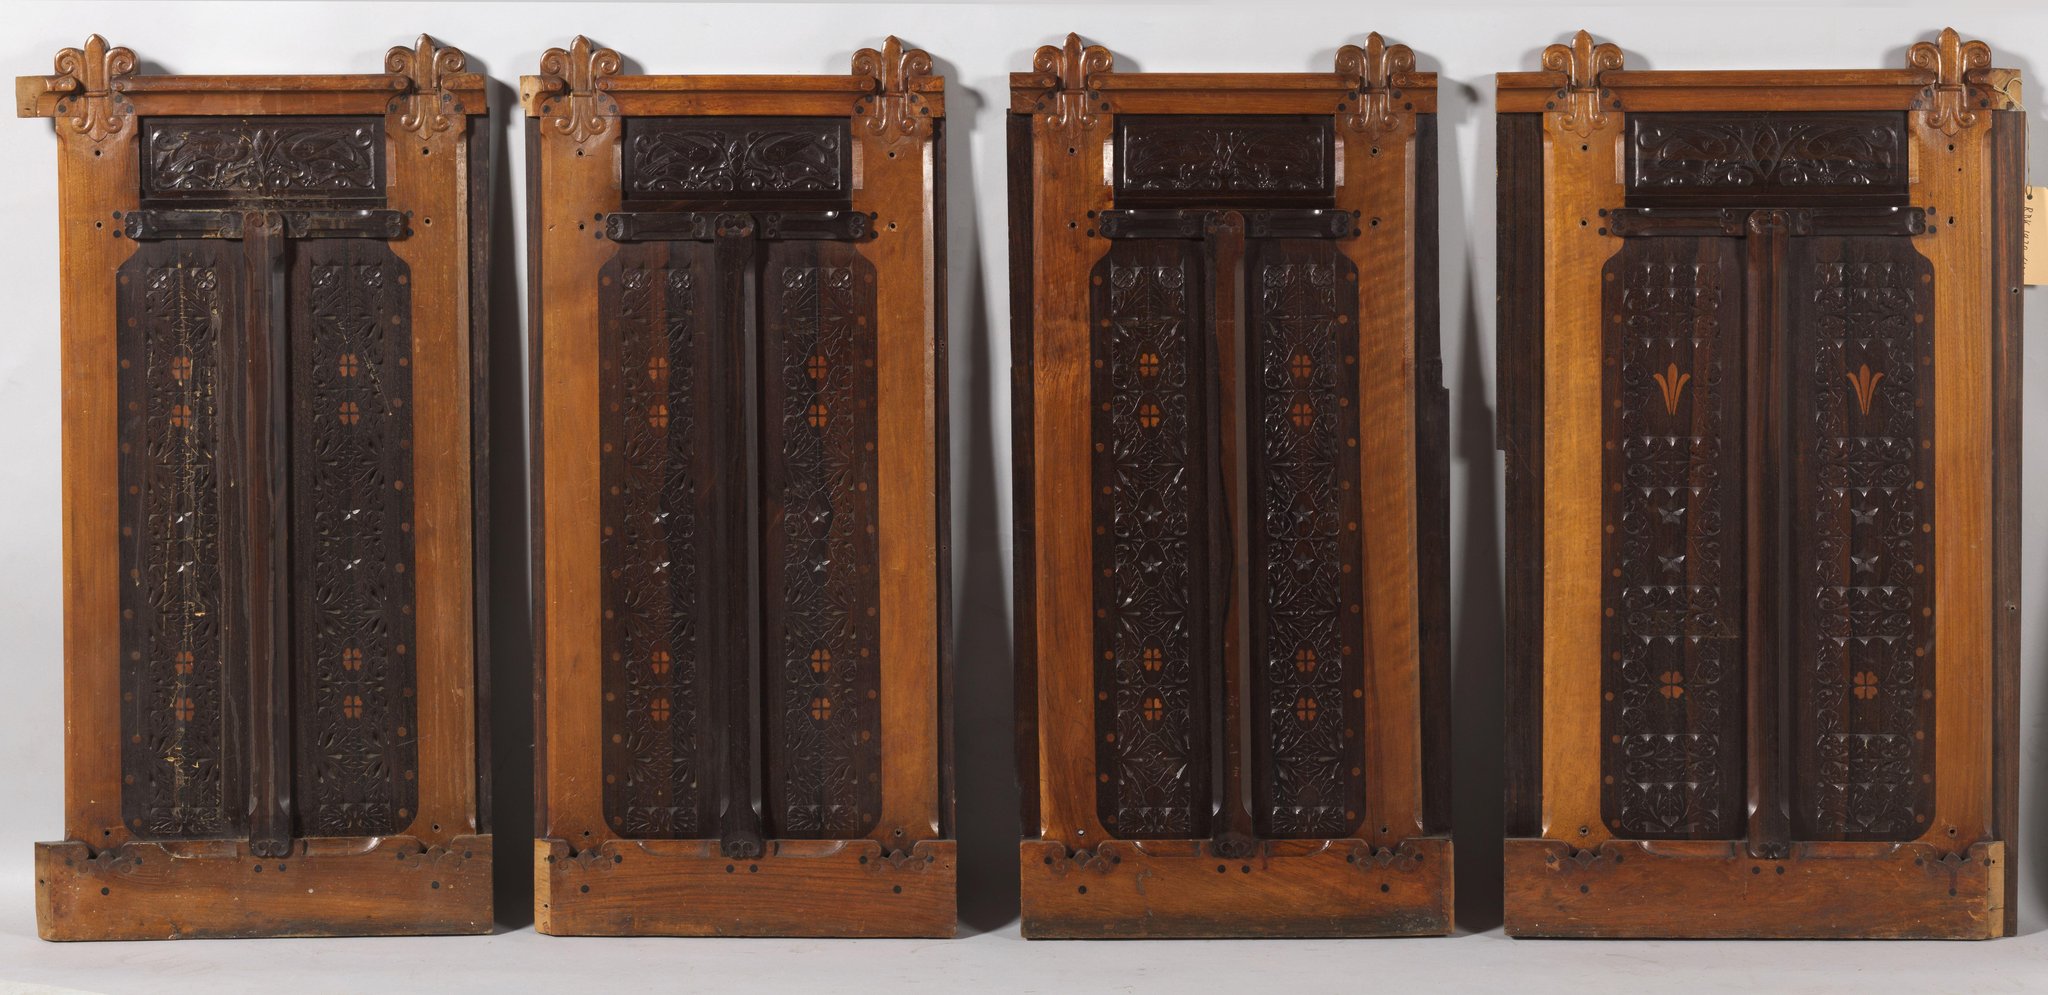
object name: betimmering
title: Deel lambrizering, afkomstig uit het huis van Dentz van Schaick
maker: carel adolph lion cachet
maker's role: draughtsman, print maker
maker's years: 1864-1945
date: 1900-1905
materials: wood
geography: amsterdam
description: Schot, deel van de lambrizering vervaardigd voor het huis van mr Th.G. Dentz van Schaick aan het Amsterdamse Frederiksplein 50-52. Dit schot bestaat uit twee verticale en één horizontaal paneel en is gemaakt van palissander en notehnout. Met blauw krijt: AB8 D1.